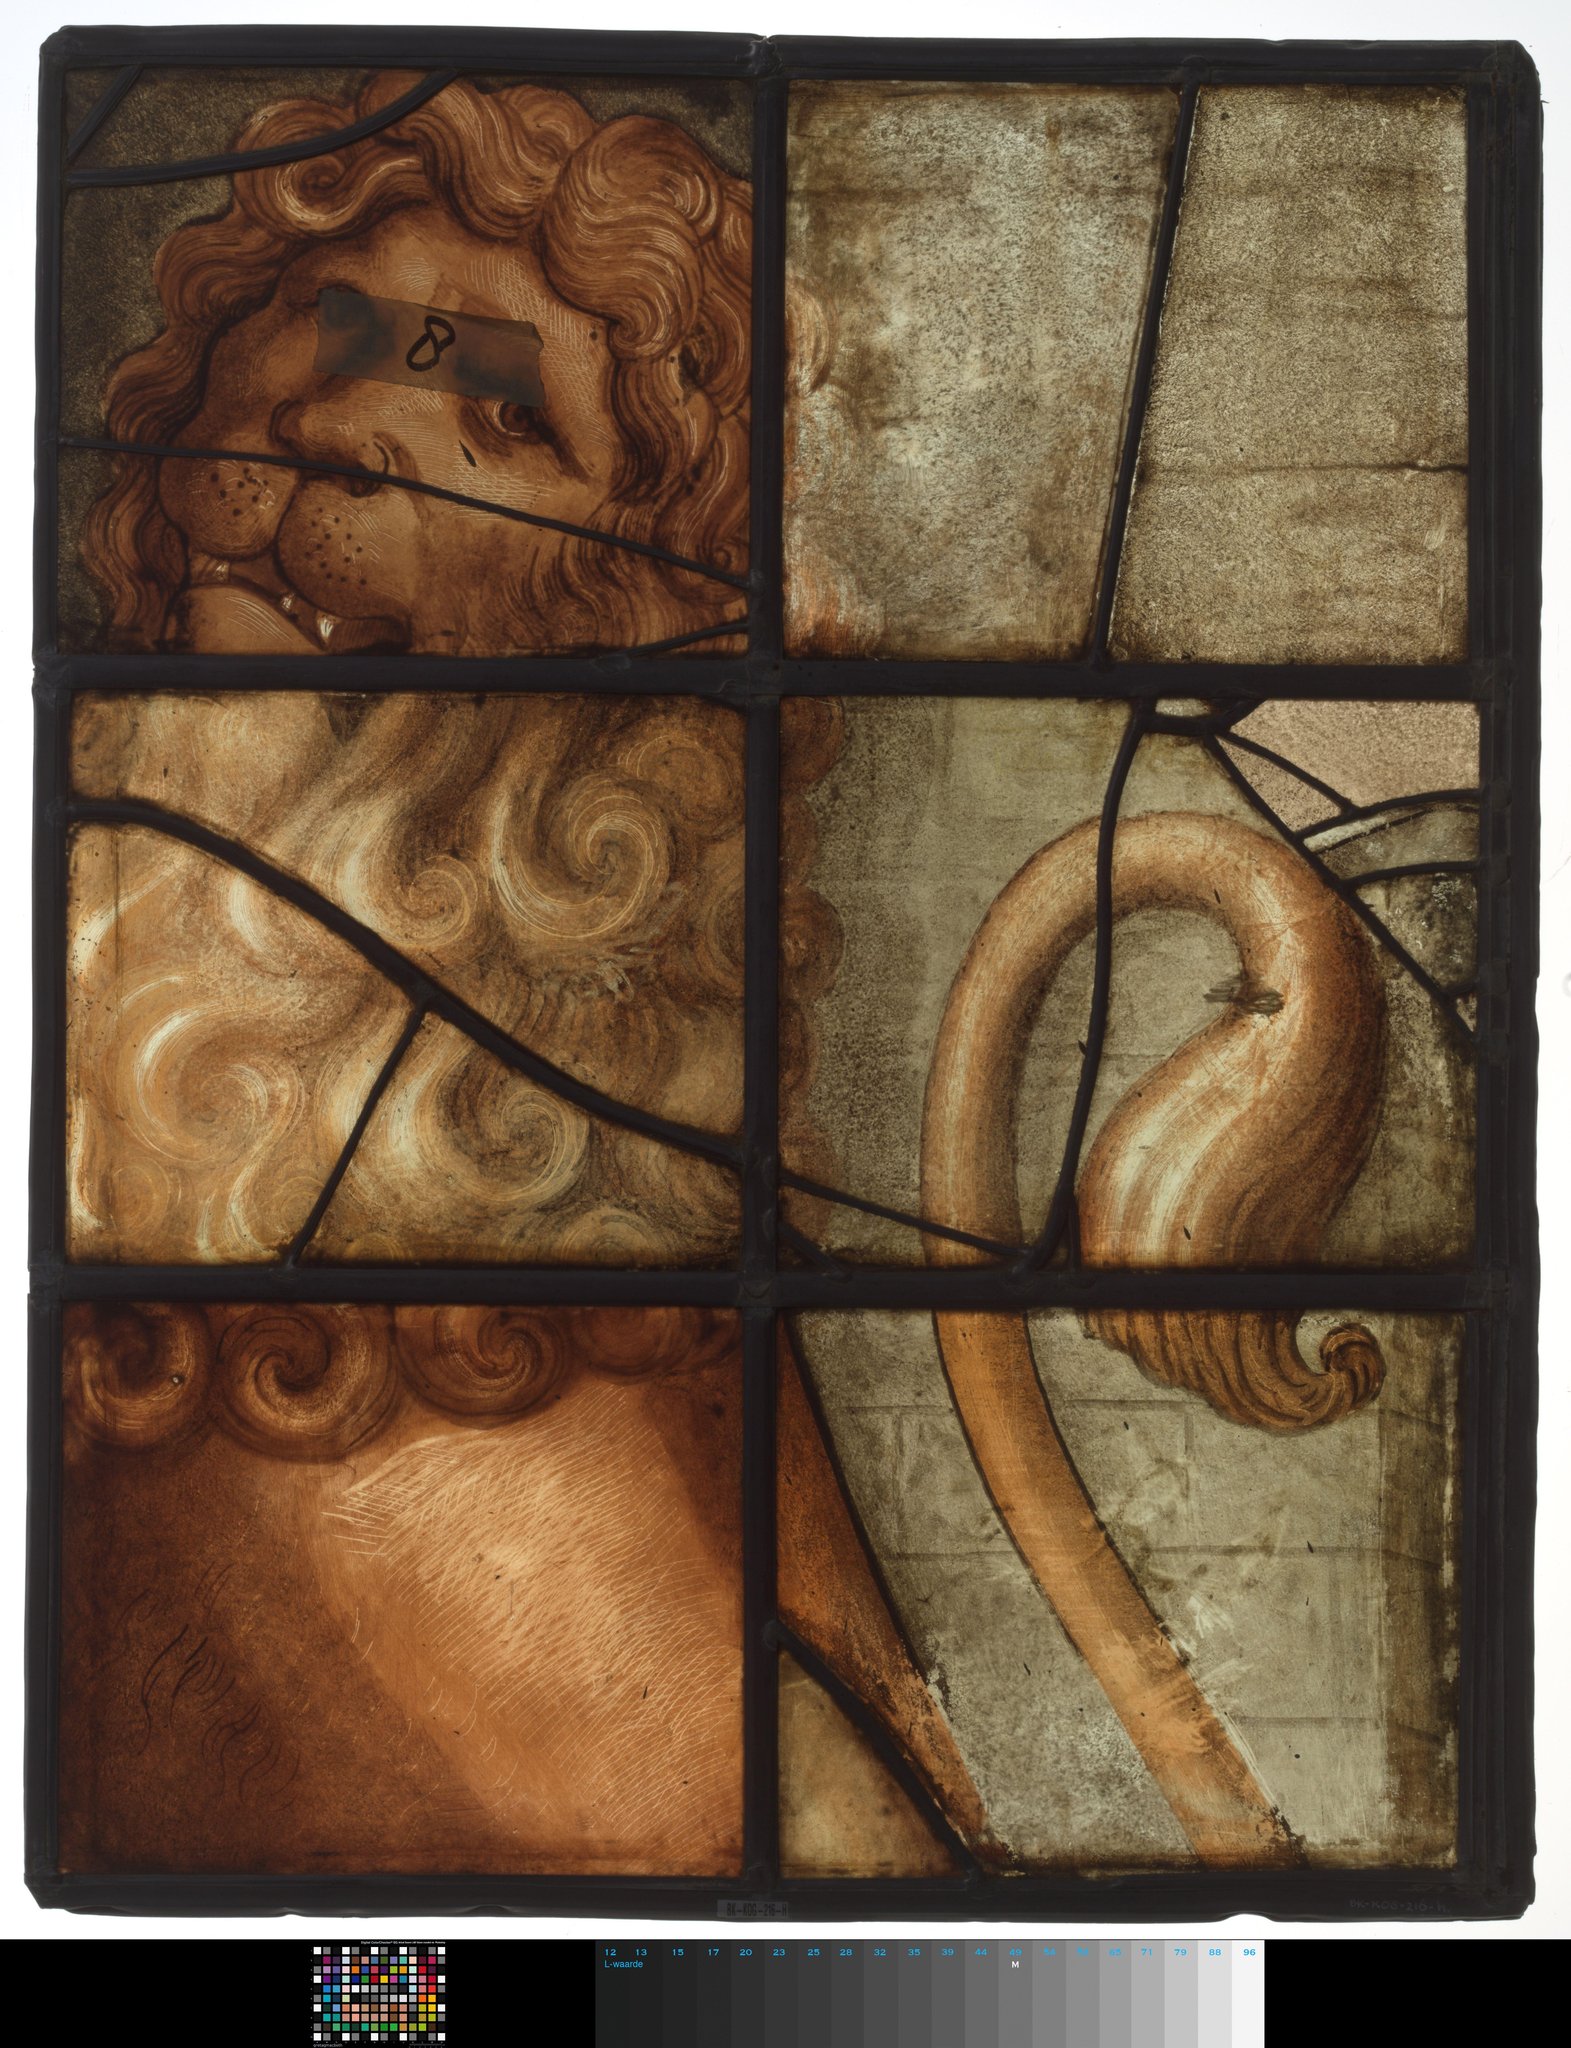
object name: light window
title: Ruit met het wapen van Alkmaar met onderschrift "Alkmaria Victrix 1573"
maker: Anonymous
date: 1573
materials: glass, lead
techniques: leading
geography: netherlands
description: Ruit, glas-in-lood, bestaande uit zestien afzonderlijke panelen die tezamen het wapen van Alkmaar laten zien. Onderschrift: ALKMARIA VICTRIX. Gedateerd 1573.